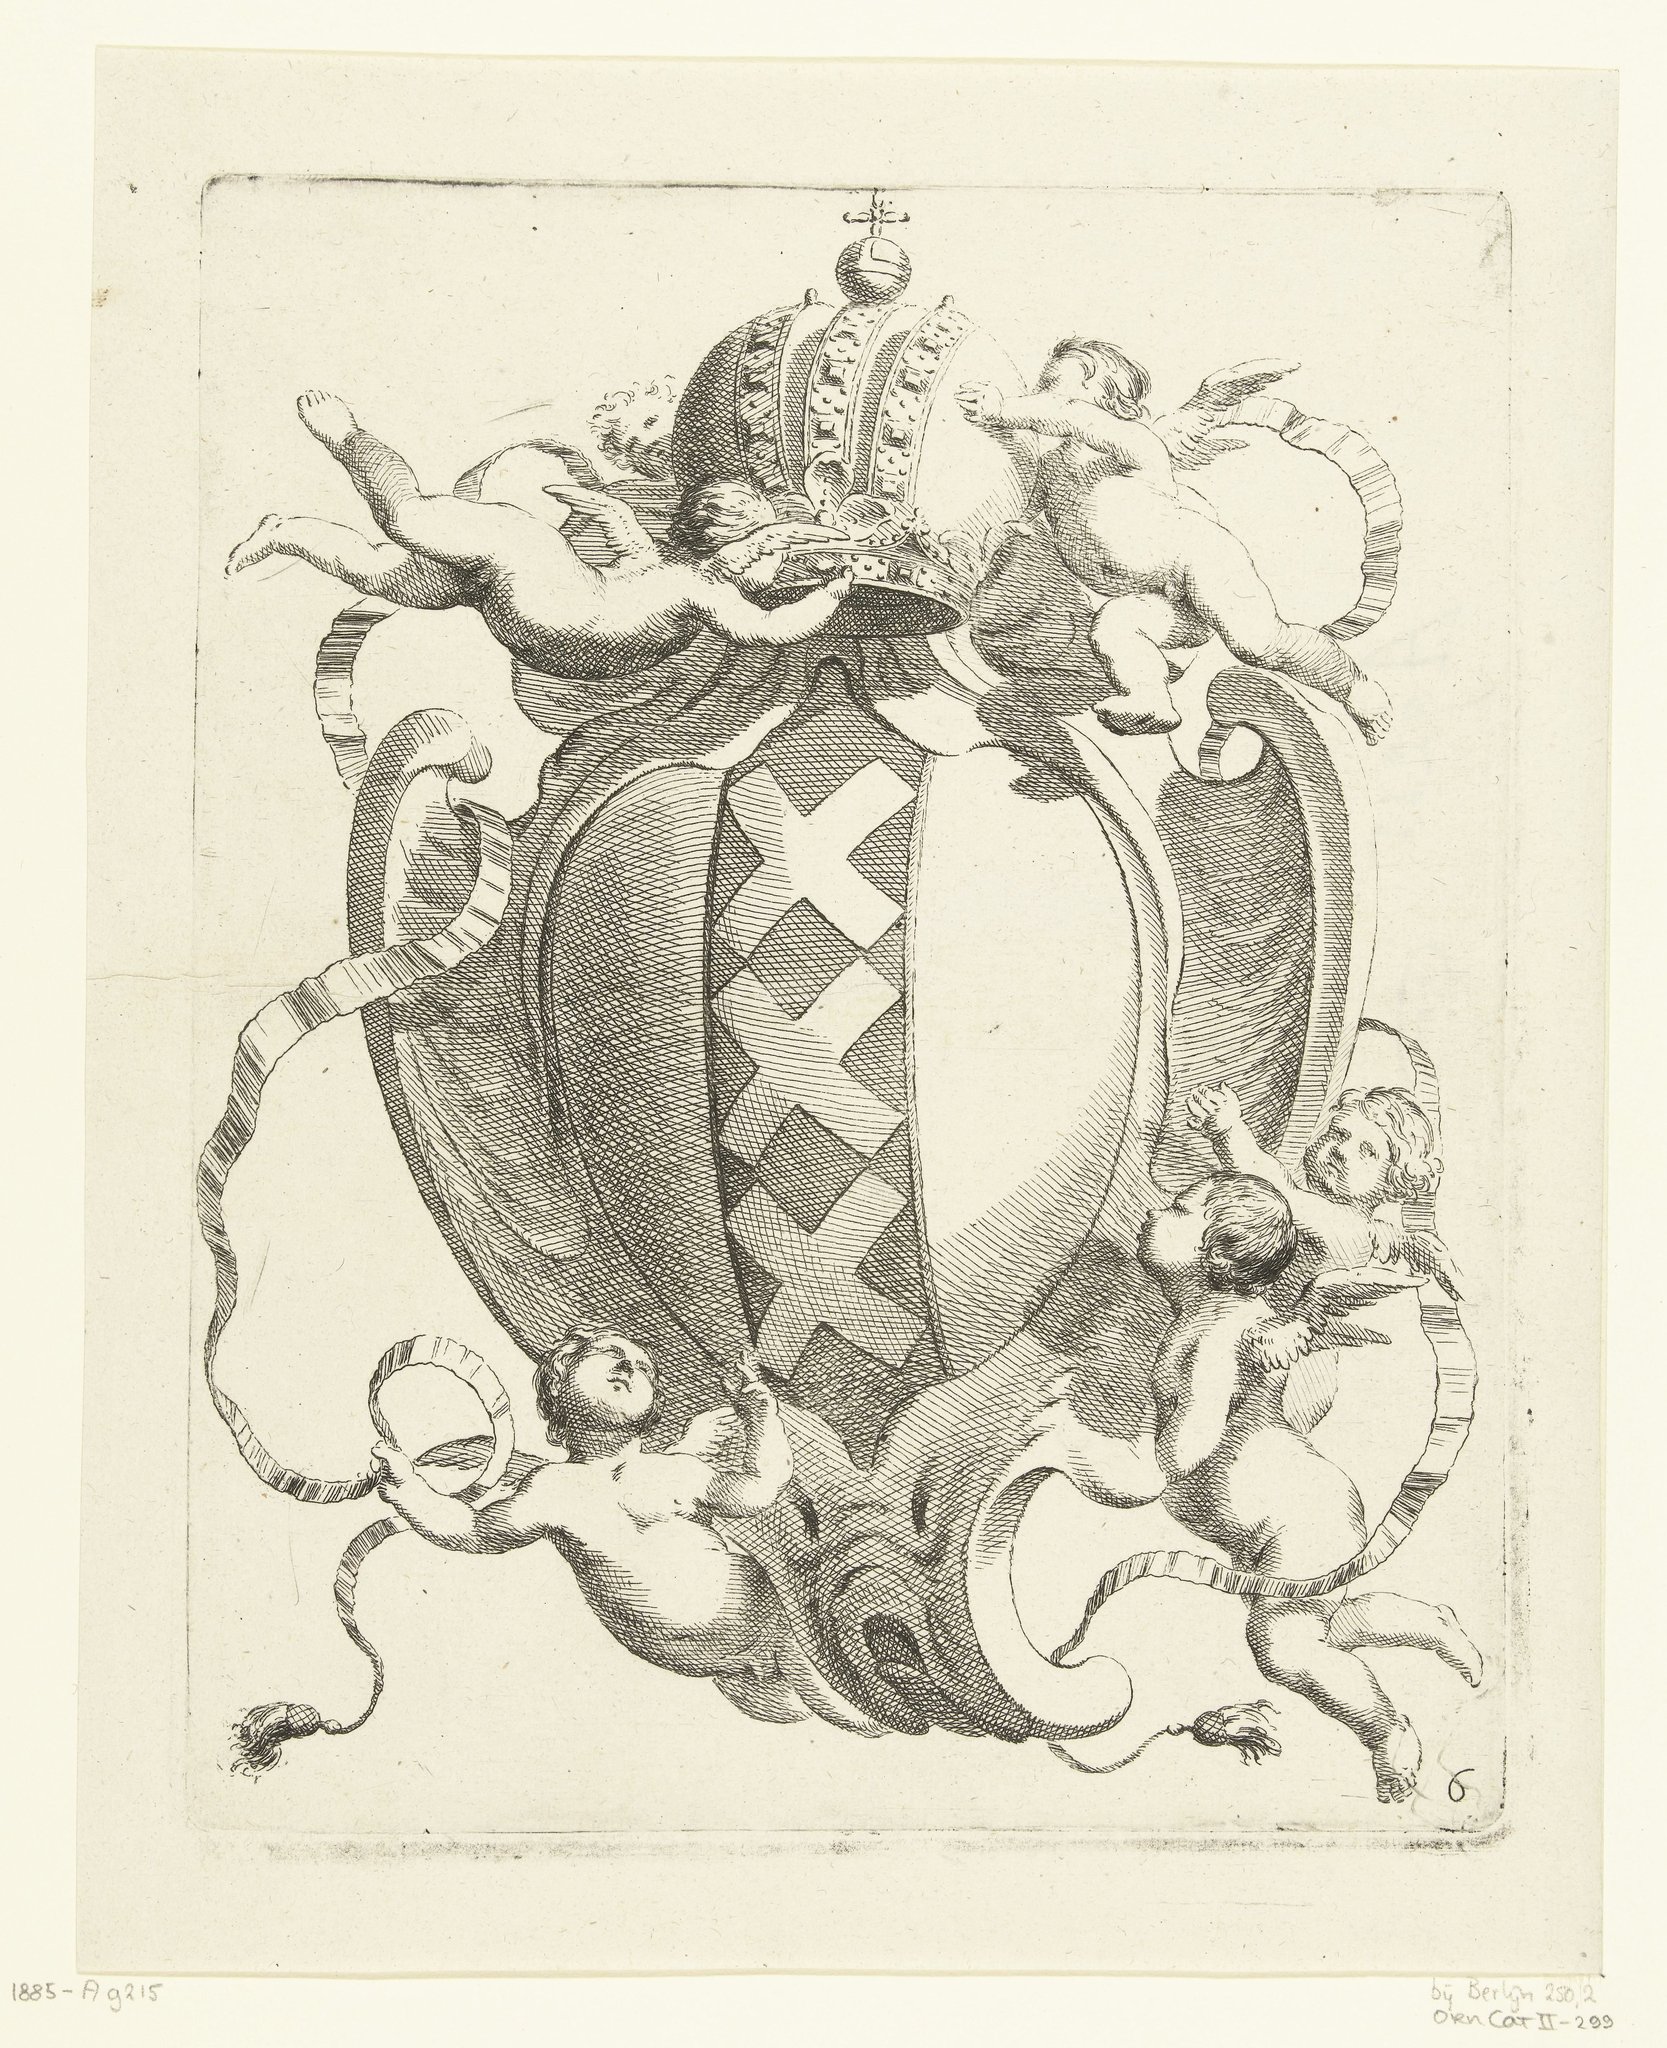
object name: print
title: Eenige nieuwe compartemente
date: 1653-1655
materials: paper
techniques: etching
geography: amsterdam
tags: coat of arms (as symbol of the state, etc.) (+ city; municipal), ornament ~ cartouche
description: De keizerskroon bovenaan wordt gedragen door putti.